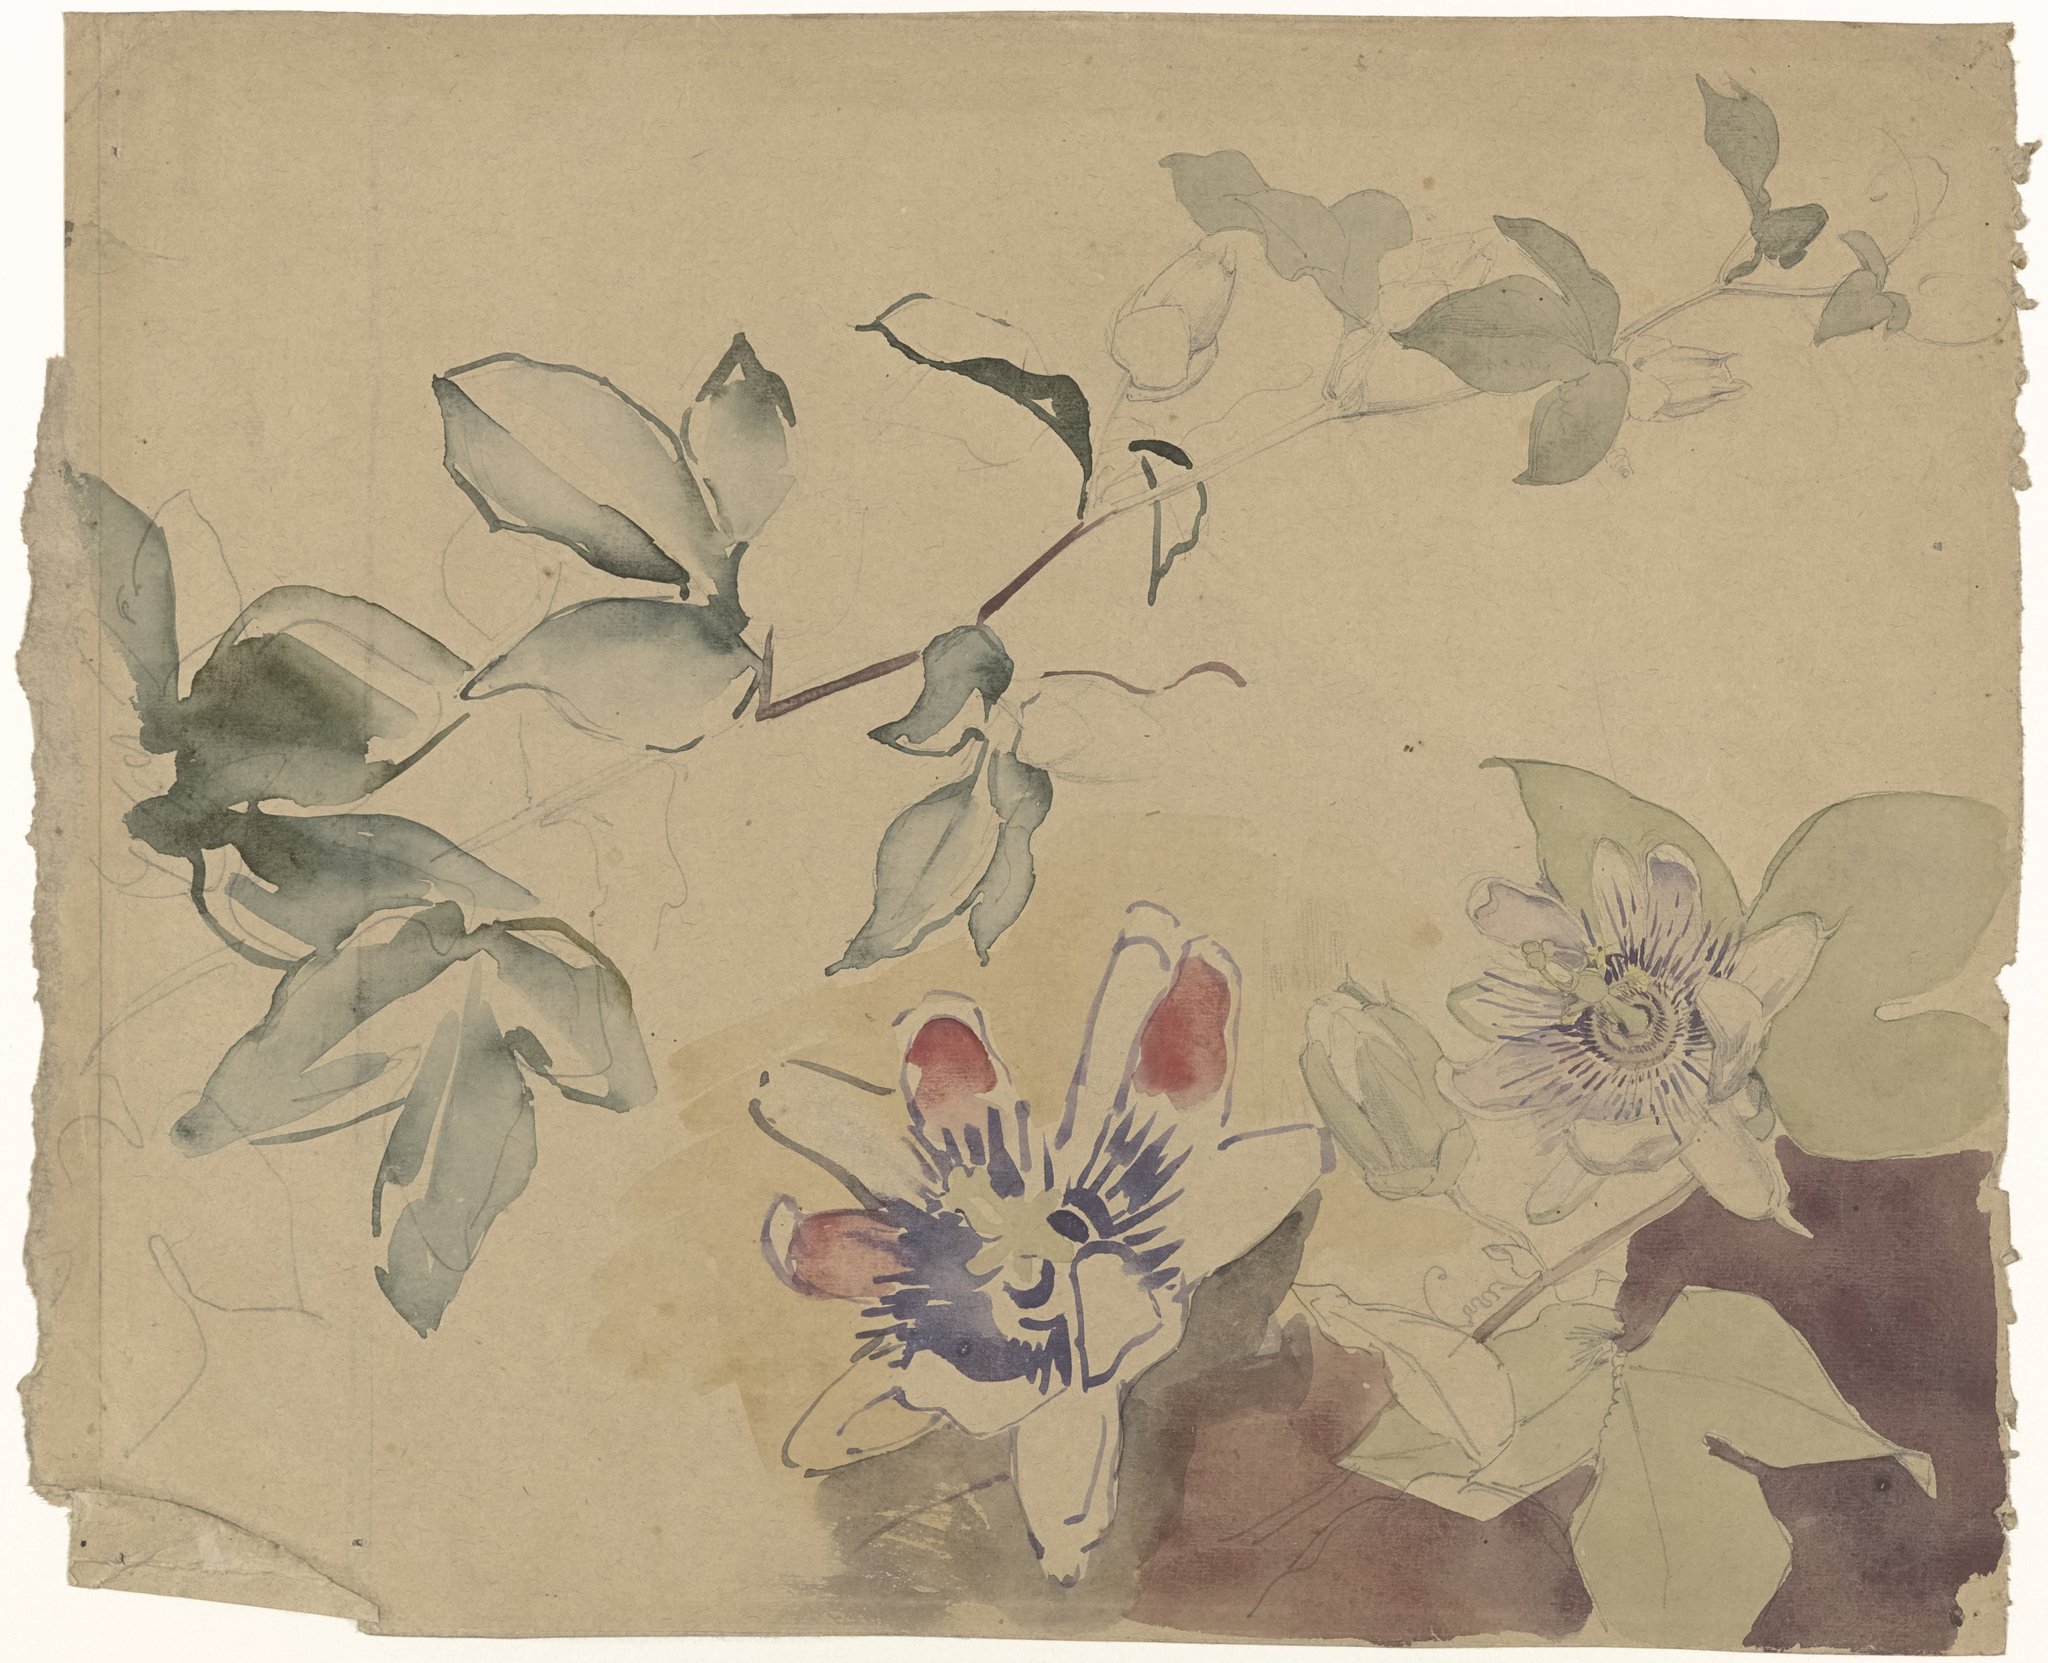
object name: drawing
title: Studieblad met passiebloemen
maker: antoon derkinderen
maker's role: draughtsman, painter, print maker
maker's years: 1859-1925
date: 1869-1925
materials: paper, pencil, watercolor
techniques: brush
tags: flowers: passion flower